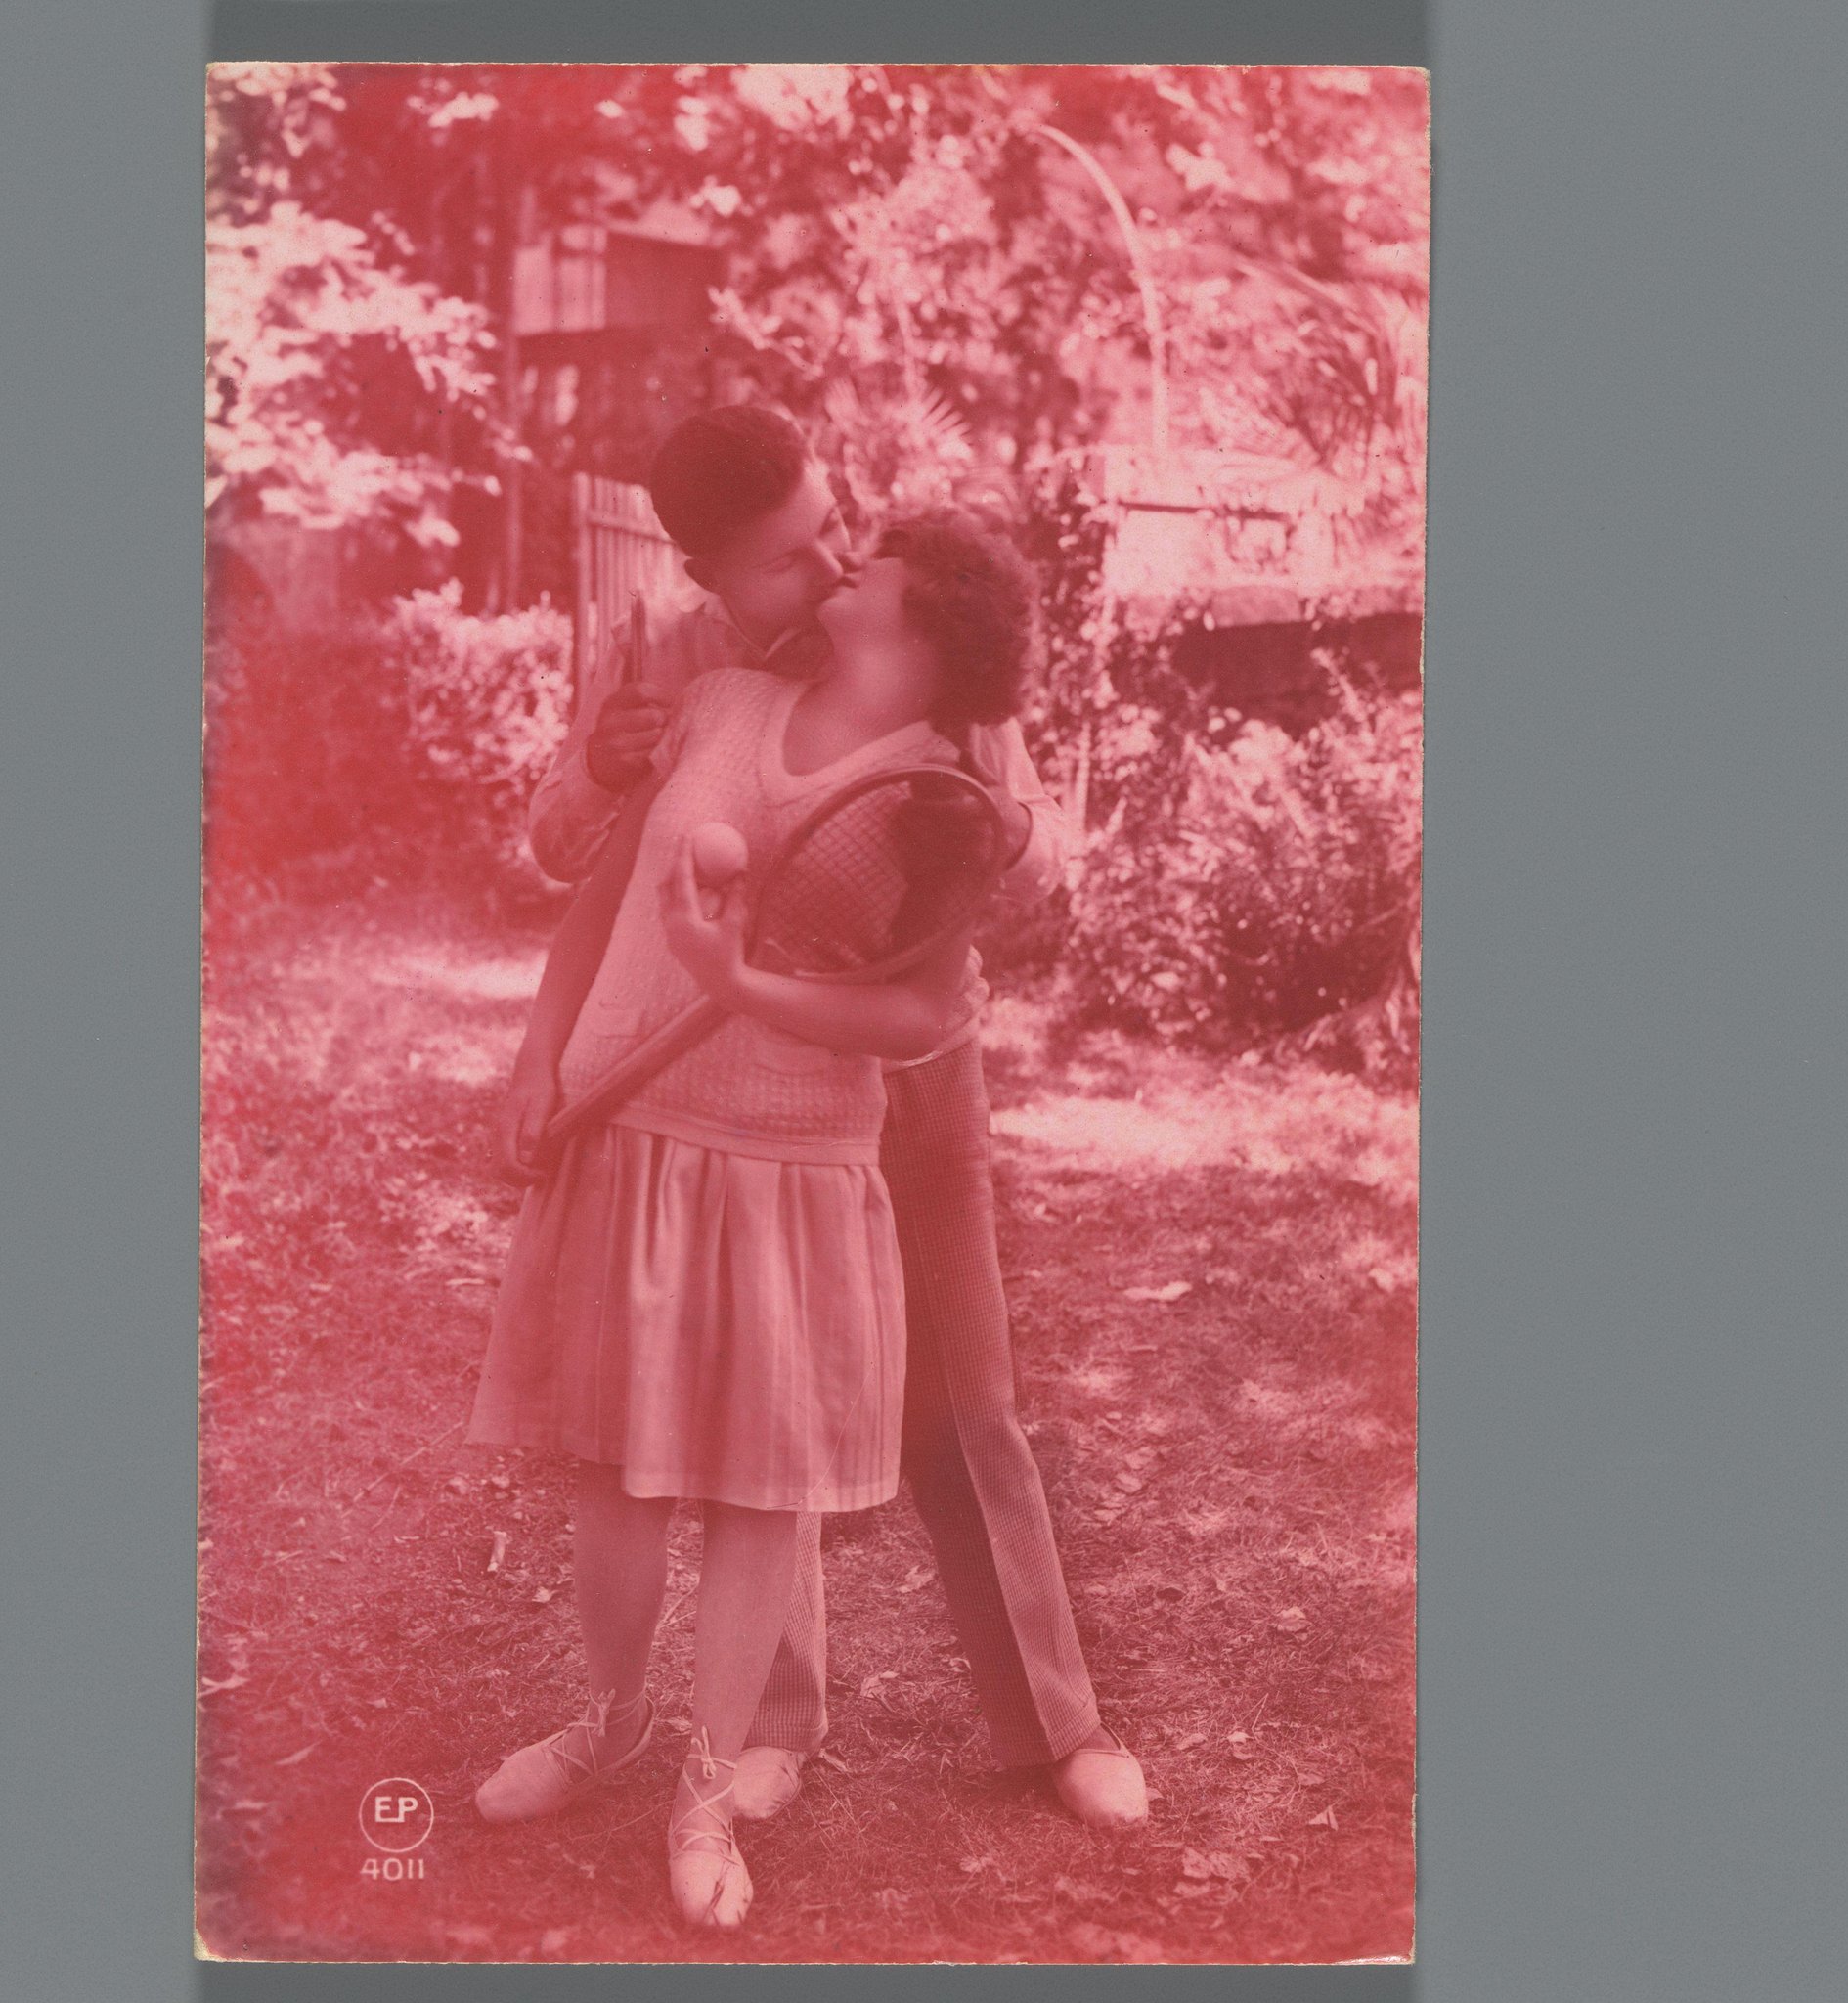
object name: ansichtkaart, prentbriefkaart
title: Portret van een onbekend kussend stel met tennisrackets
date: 1920-1940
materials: paper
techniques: gelatin silver print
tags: anonymous historical persons portrayed in a double portrait, couple of lovers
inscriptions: number: ‘4011’